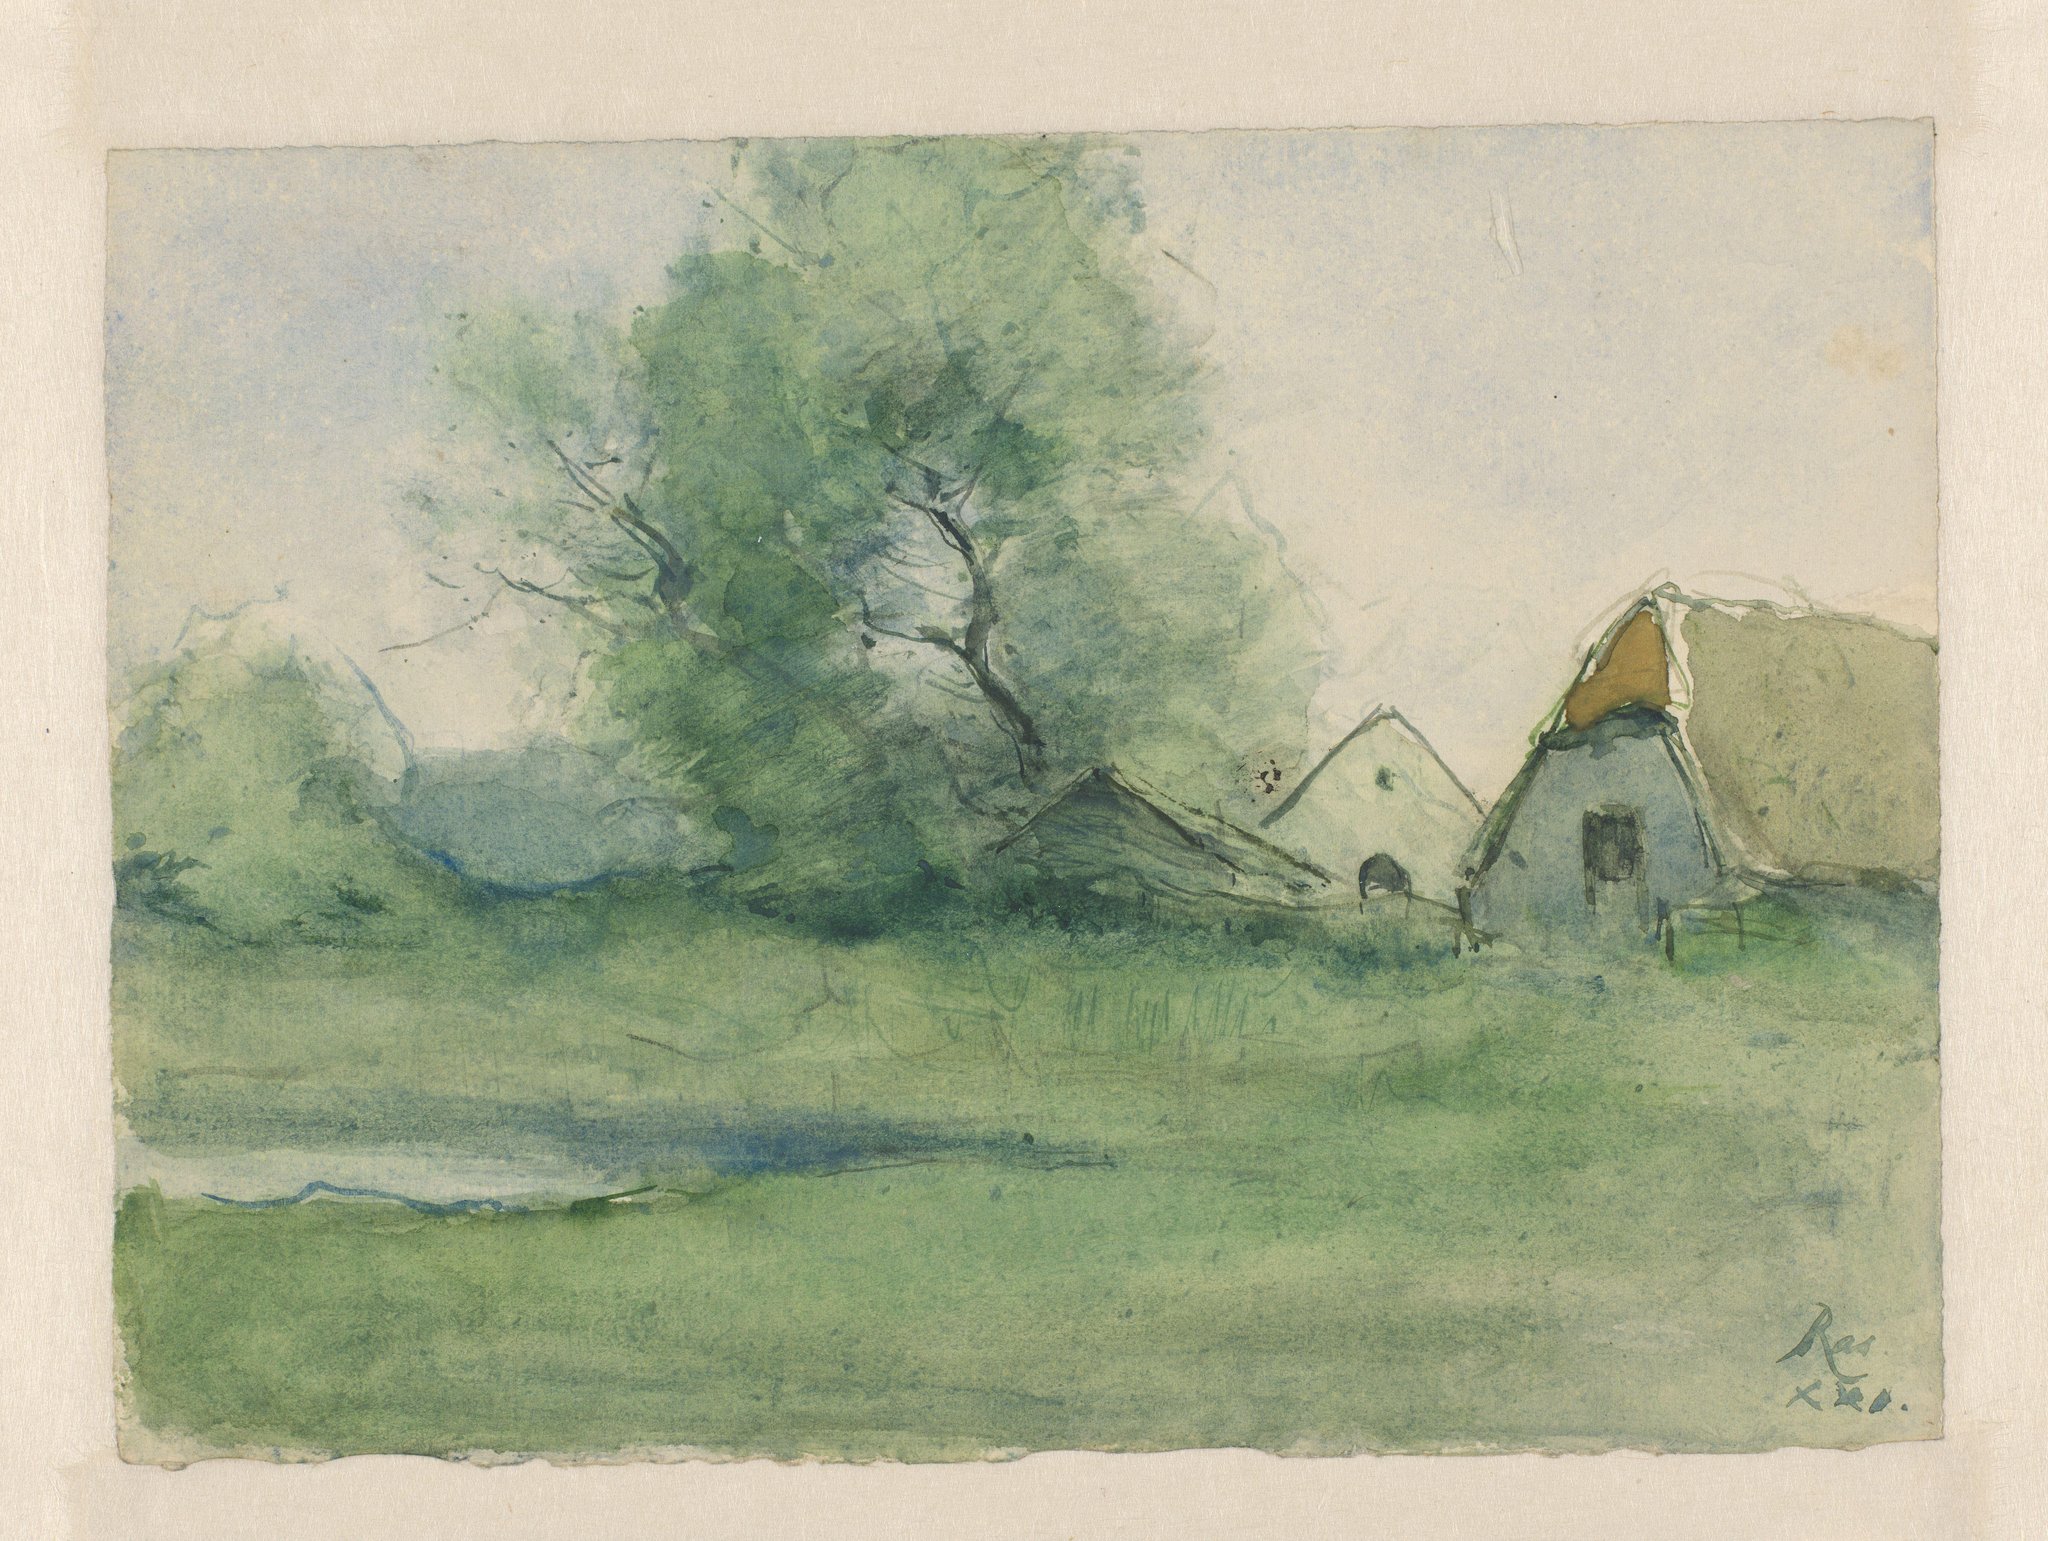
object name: drawing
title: Boerderij met bomen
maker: pieter h.j.j. ras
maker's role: draughtsman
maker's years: 1857-1941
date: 1921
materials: paper, watercolor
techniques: brush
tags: farm (building)